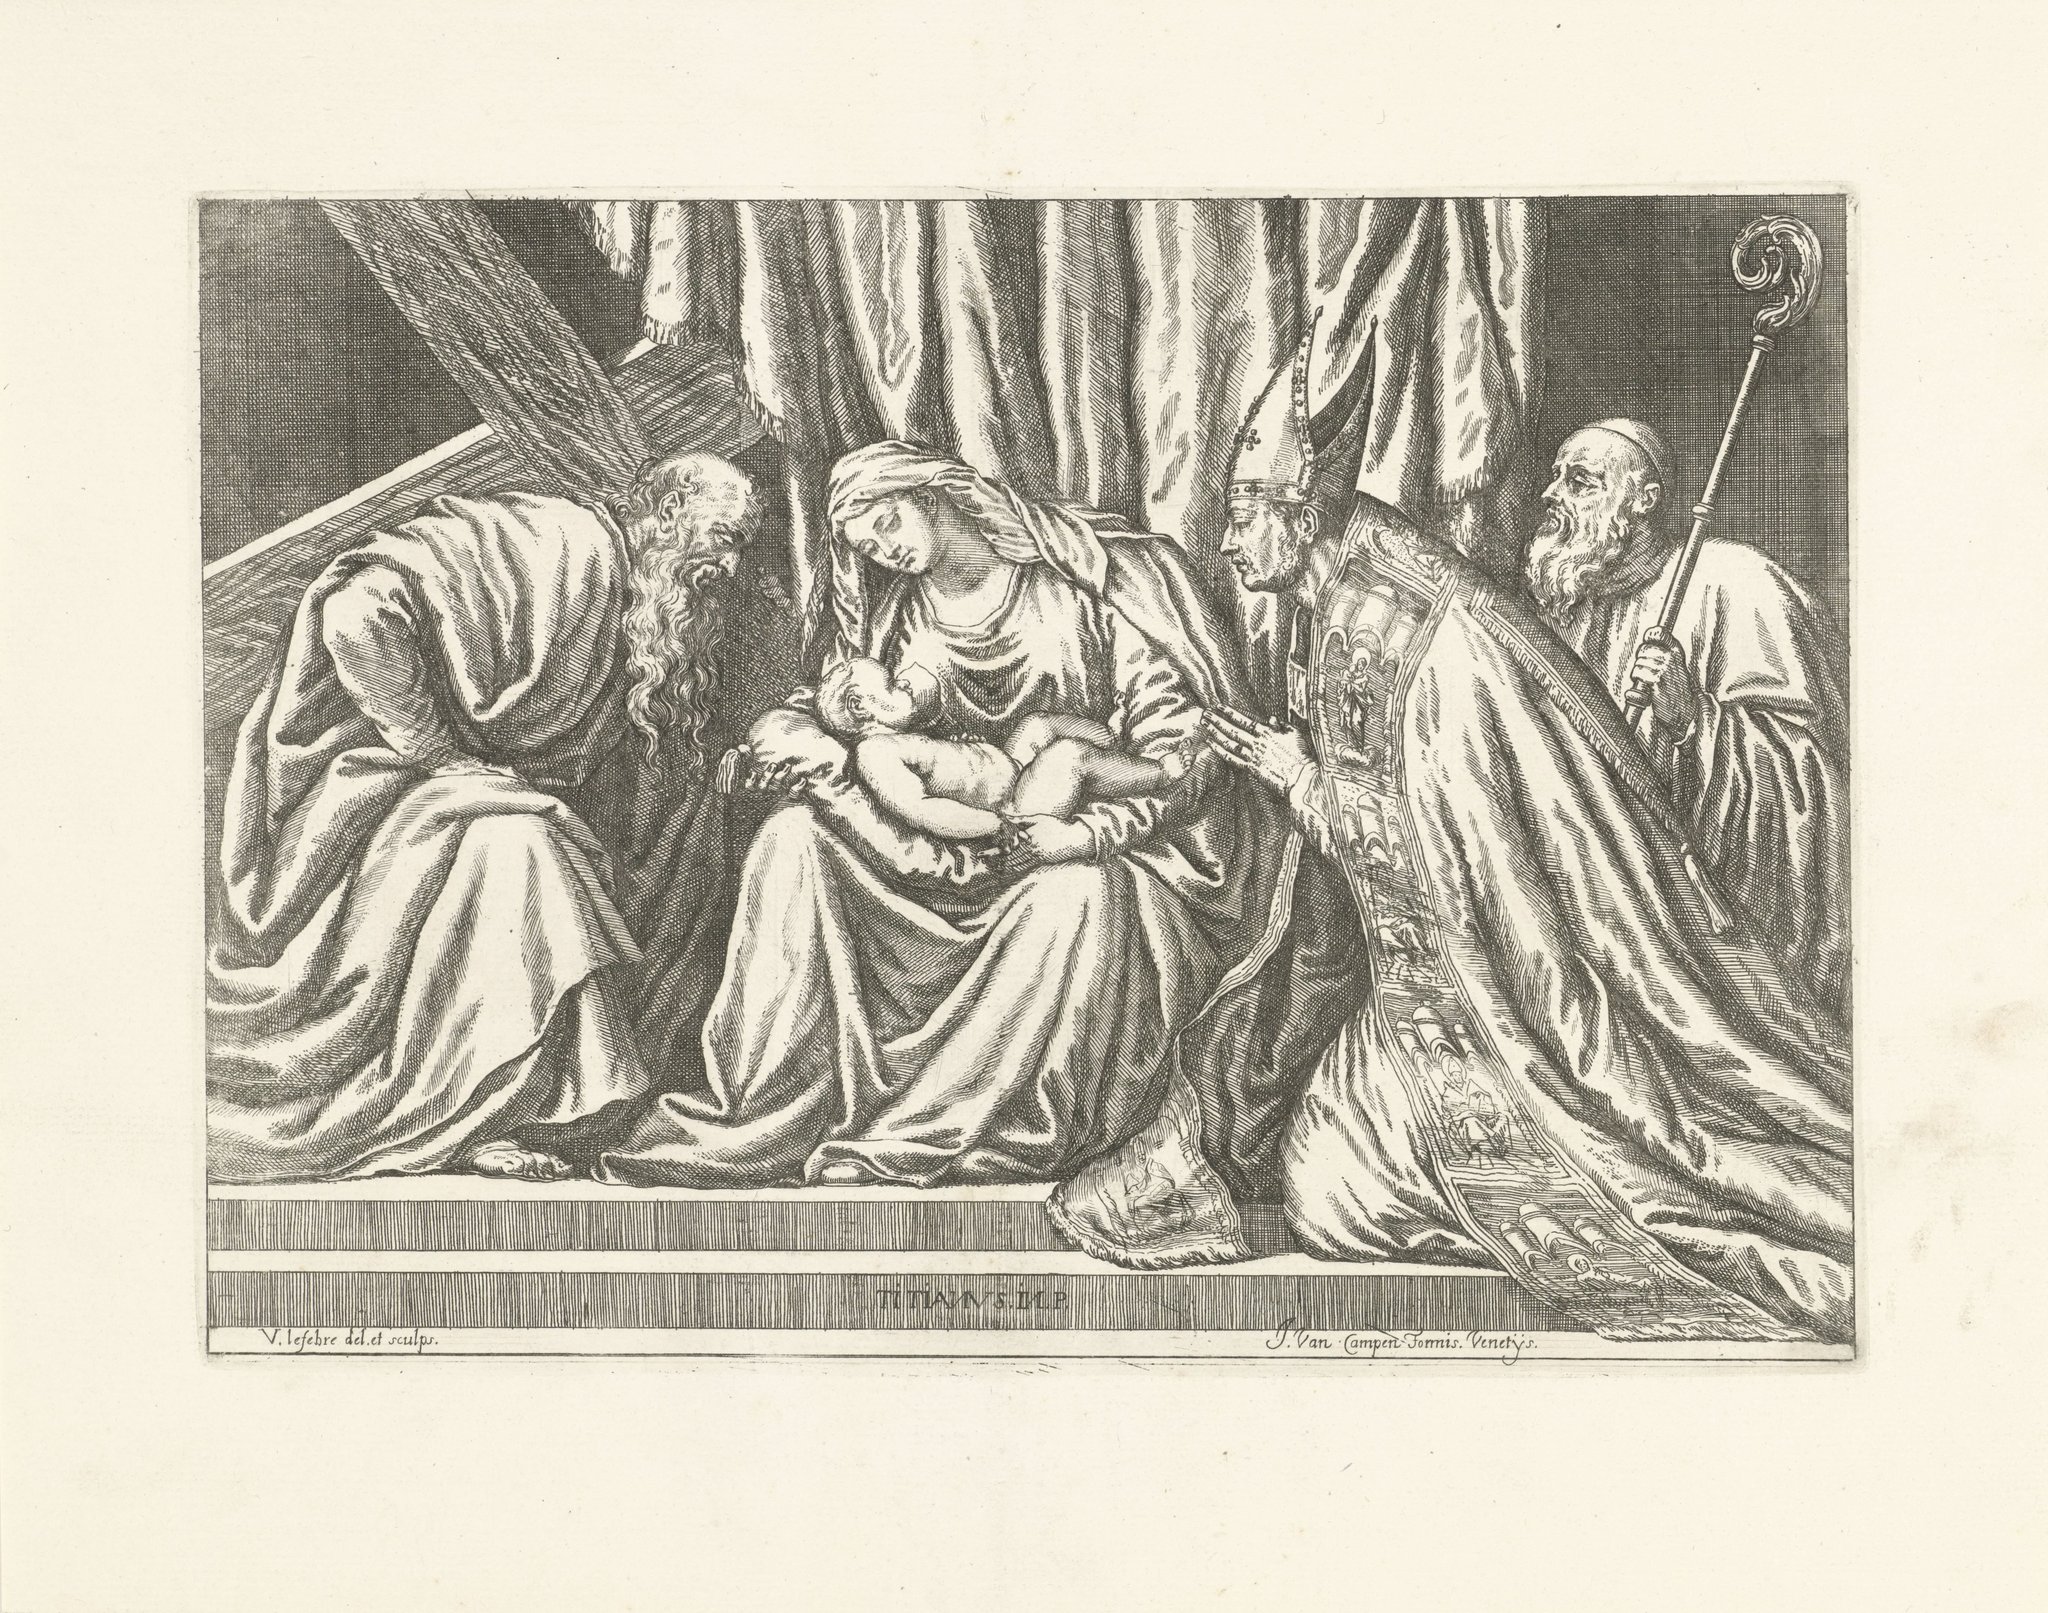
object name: print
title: Maria voedt het Christuskind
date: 1682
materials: paper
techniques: etching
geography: venice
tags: venice, painter, draughtsman, titiaan, archbishop, bishop, etc. (roman catholic), the apostle andrew; possible attributes: book, x-shaped cross, fish, fishing-net, rope, scroll, mary giving milk from her breasts, 'lactatio'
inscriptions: collector's mark: Lugt 2228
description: Maria geeft het Christuskind, liggend op een kussen op haar schoot, de borst. Links knielt de apostel Andreas met een kruis op zijn rug, rechts aanbidt bisschop Tiziano di Oderzo het kind. De schilder Titiaan kijkt uiterst rechts met een bisschopsstaf in zijn hand toe. De prent maakt deel uit van een 53-delige serie prenten naar schilderijen van Titiaan en Veronese.